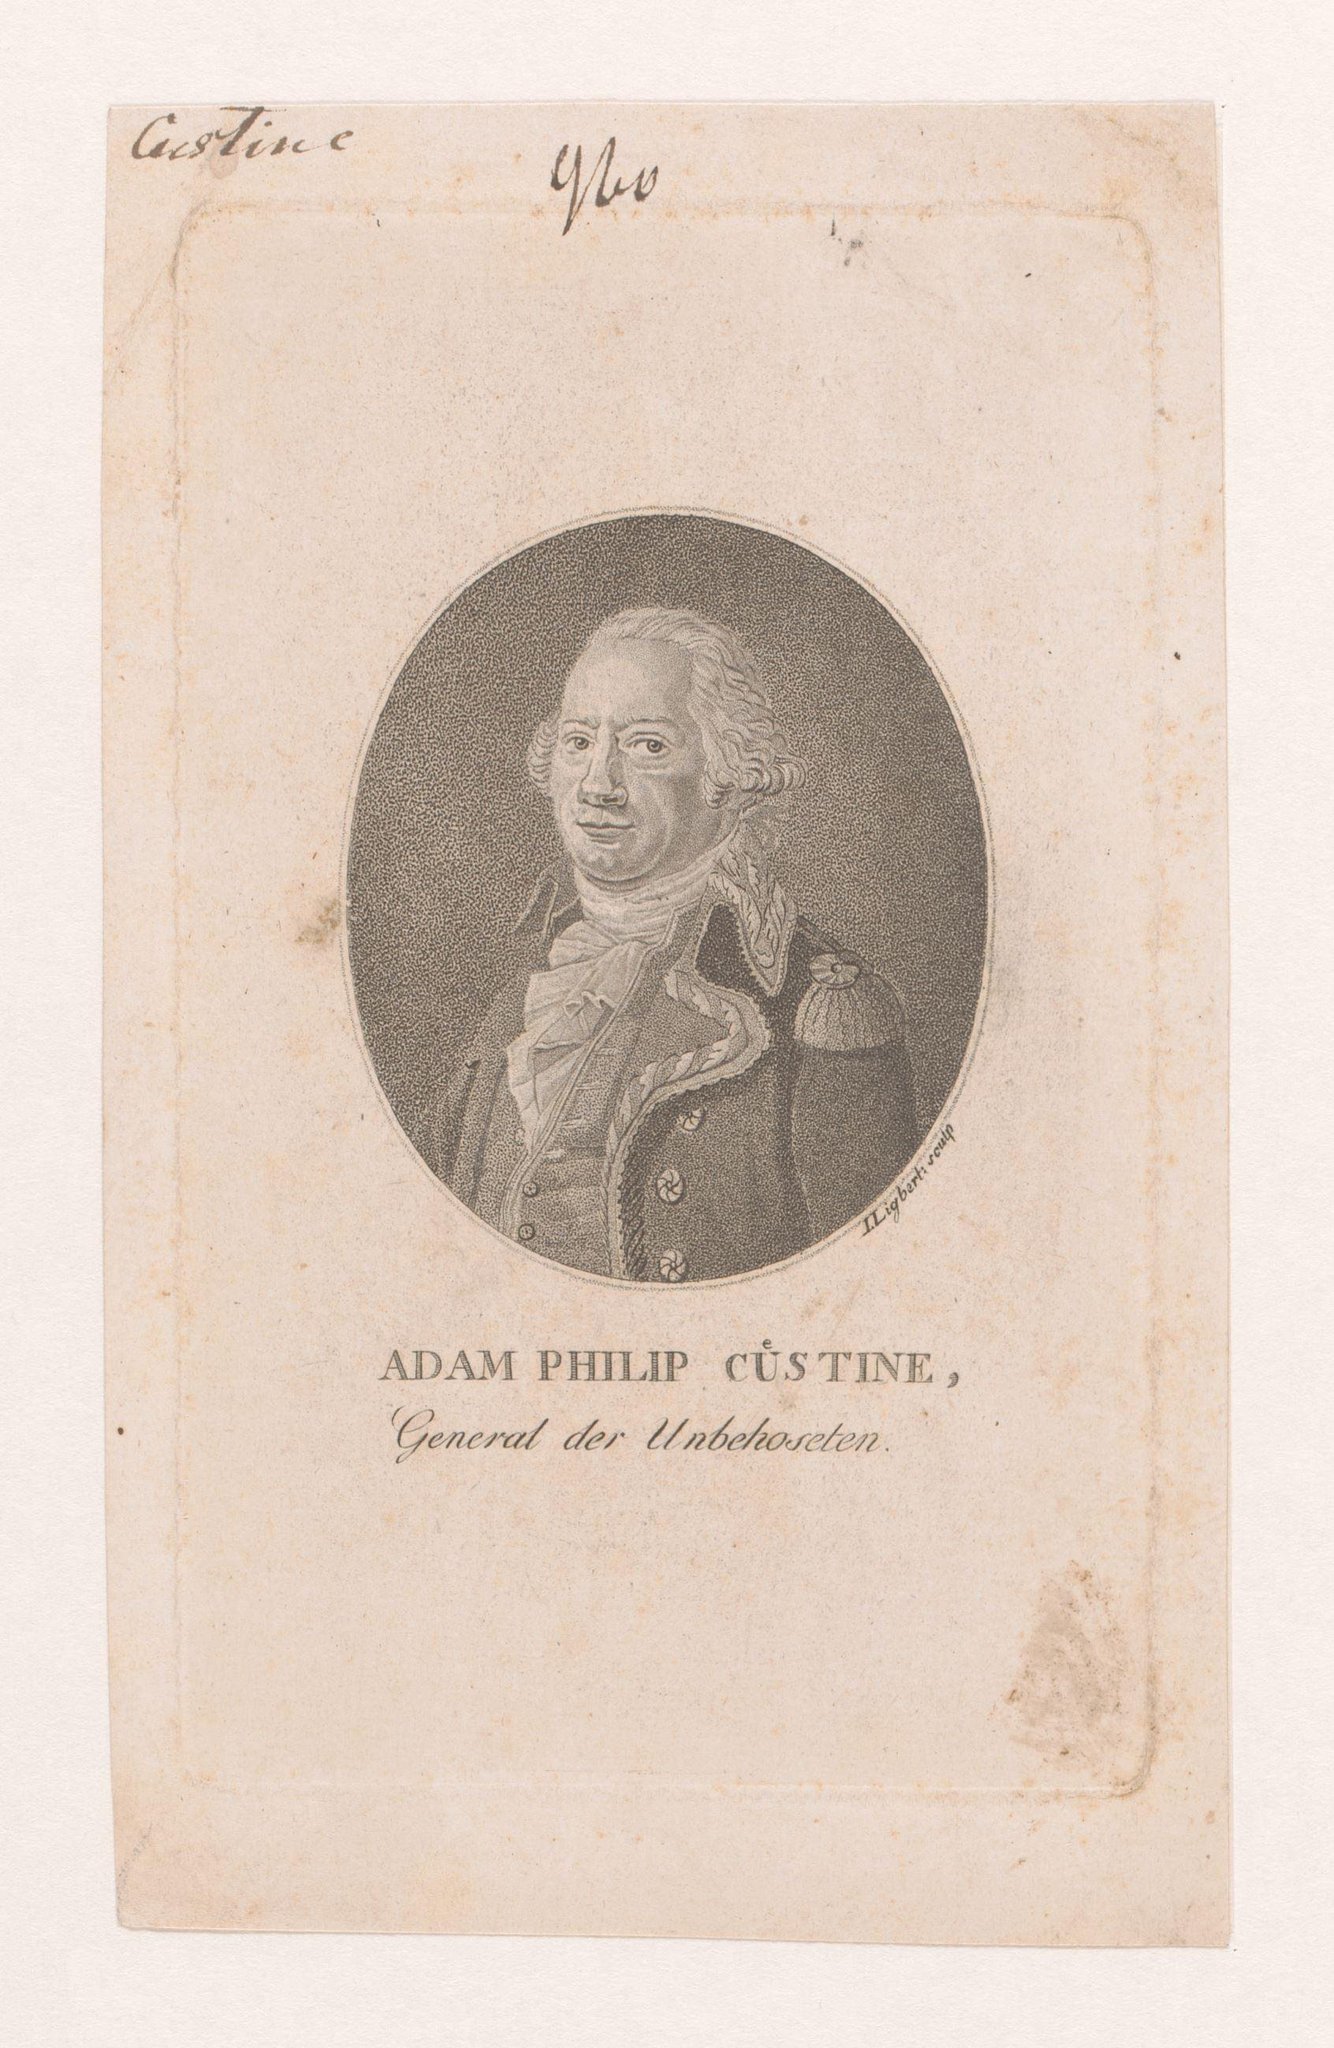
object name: print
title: Portret van Adam-Philippe Custine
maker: johann ligber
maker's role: print maker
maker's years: -1814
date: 1763-1814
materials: paper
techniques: etching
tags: commander-in-chief, general, marshal, historical persons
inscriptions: collector's mark: Lugt 2228